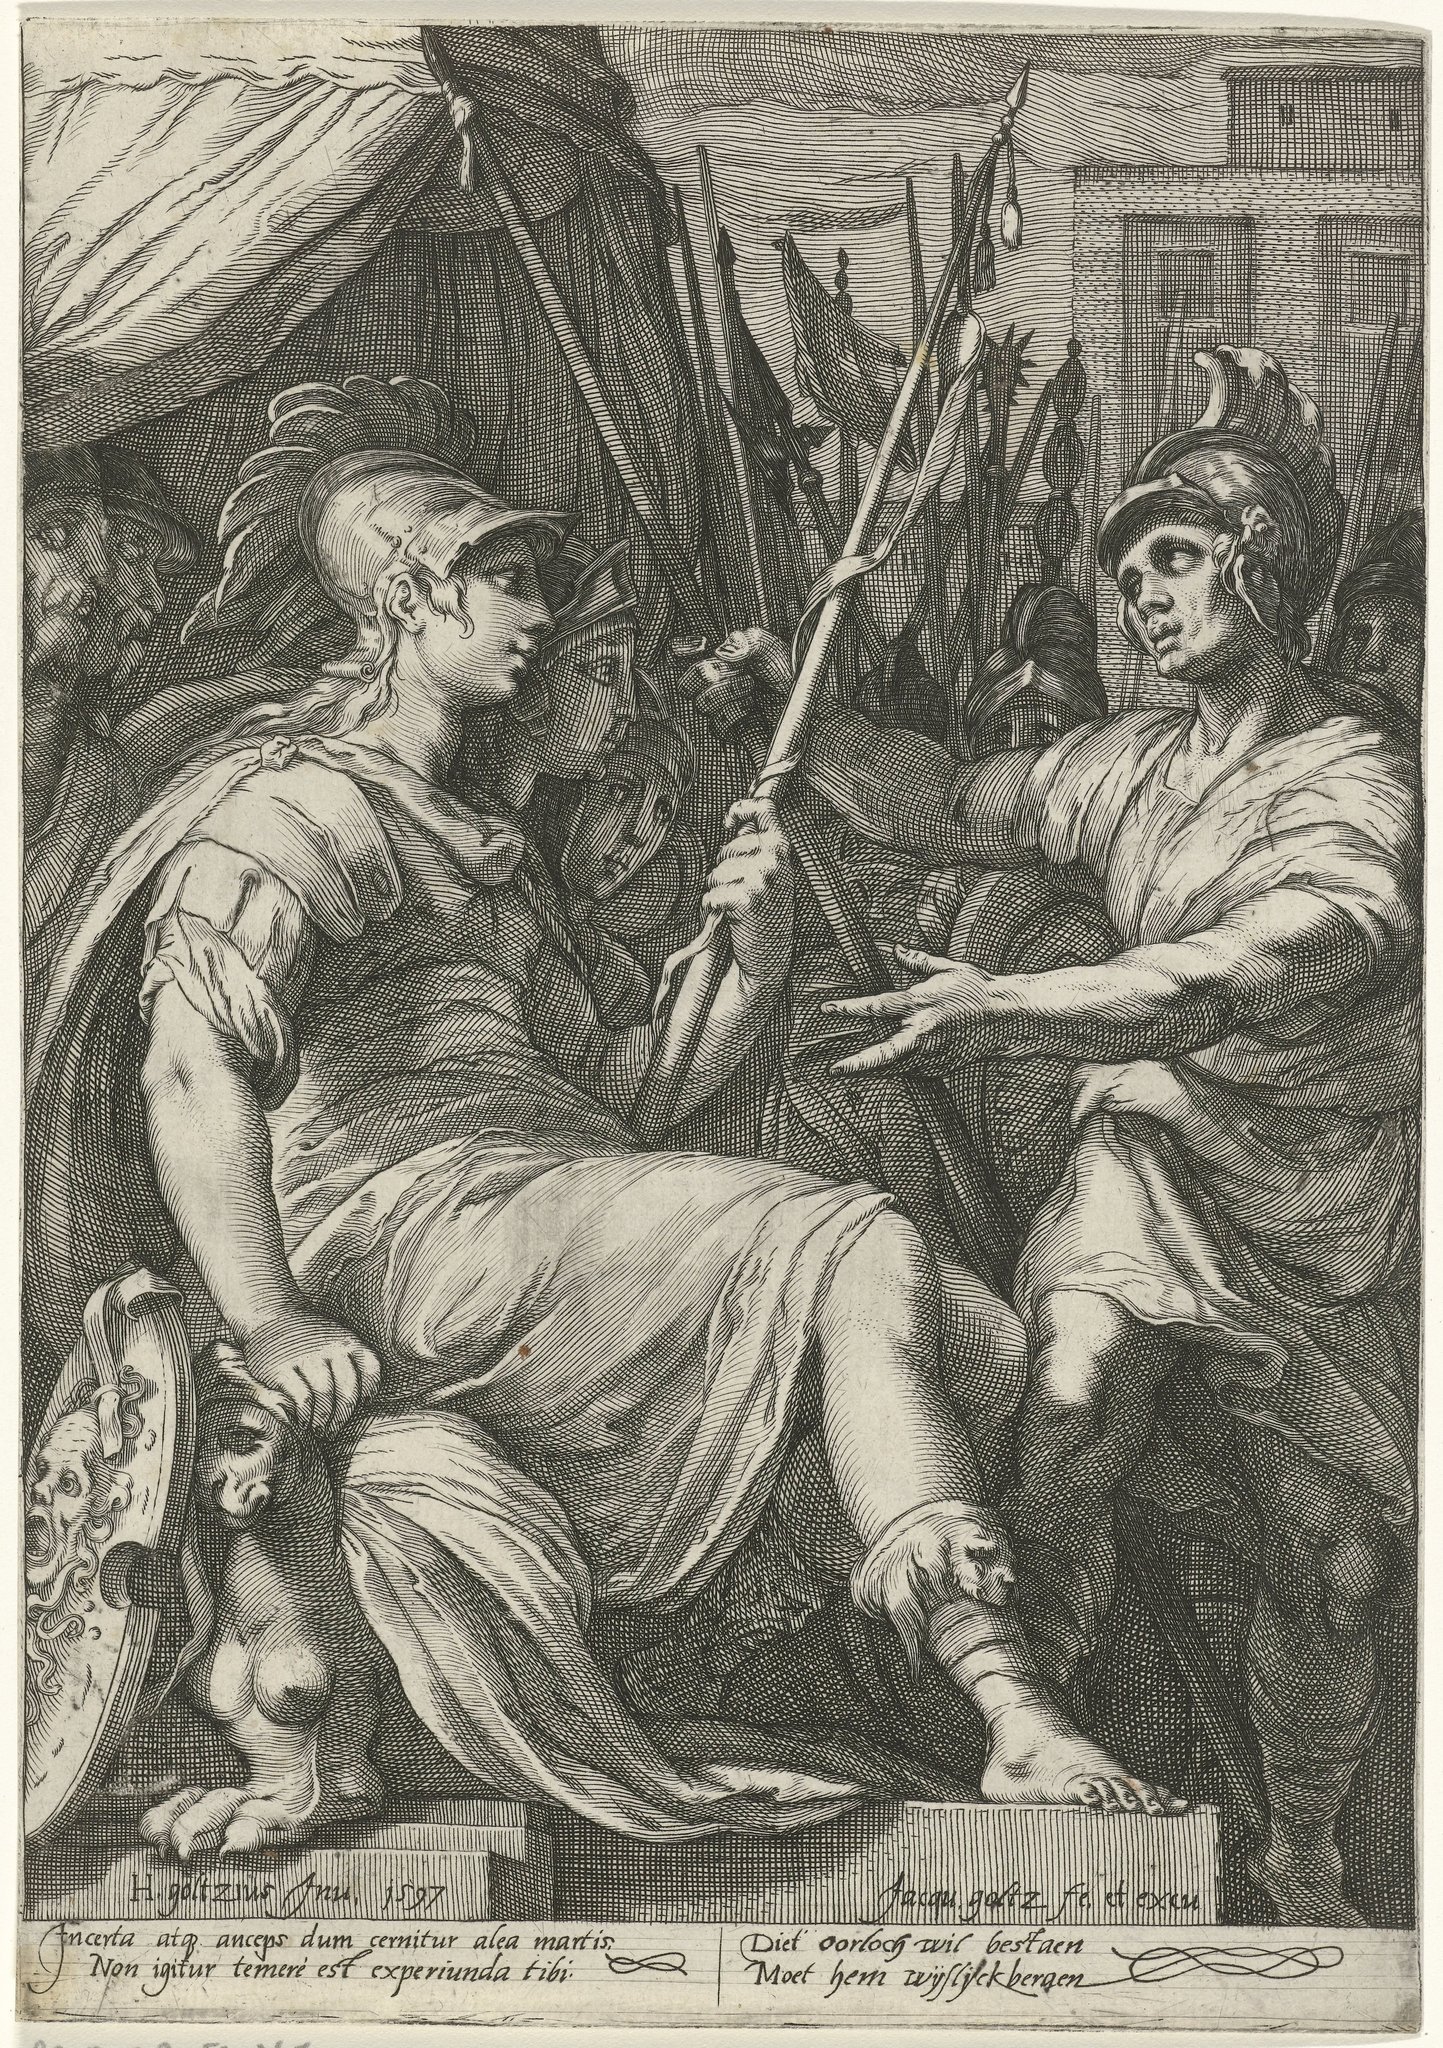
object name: print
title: Minerva omgeven door krijgers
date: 1597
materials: paper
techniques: engraving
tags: (story of) minerva (pallas, athena), private soldier, proverbs, sayings, etc.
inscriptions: number: ‘n. 462’, collector's mark: Lugt 240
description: De godin Minerva in harnas zit op een troon. Rondom haar soldaten. De prent heeft een Latijns en Nederlands onderschrift met een wijze spreuk.